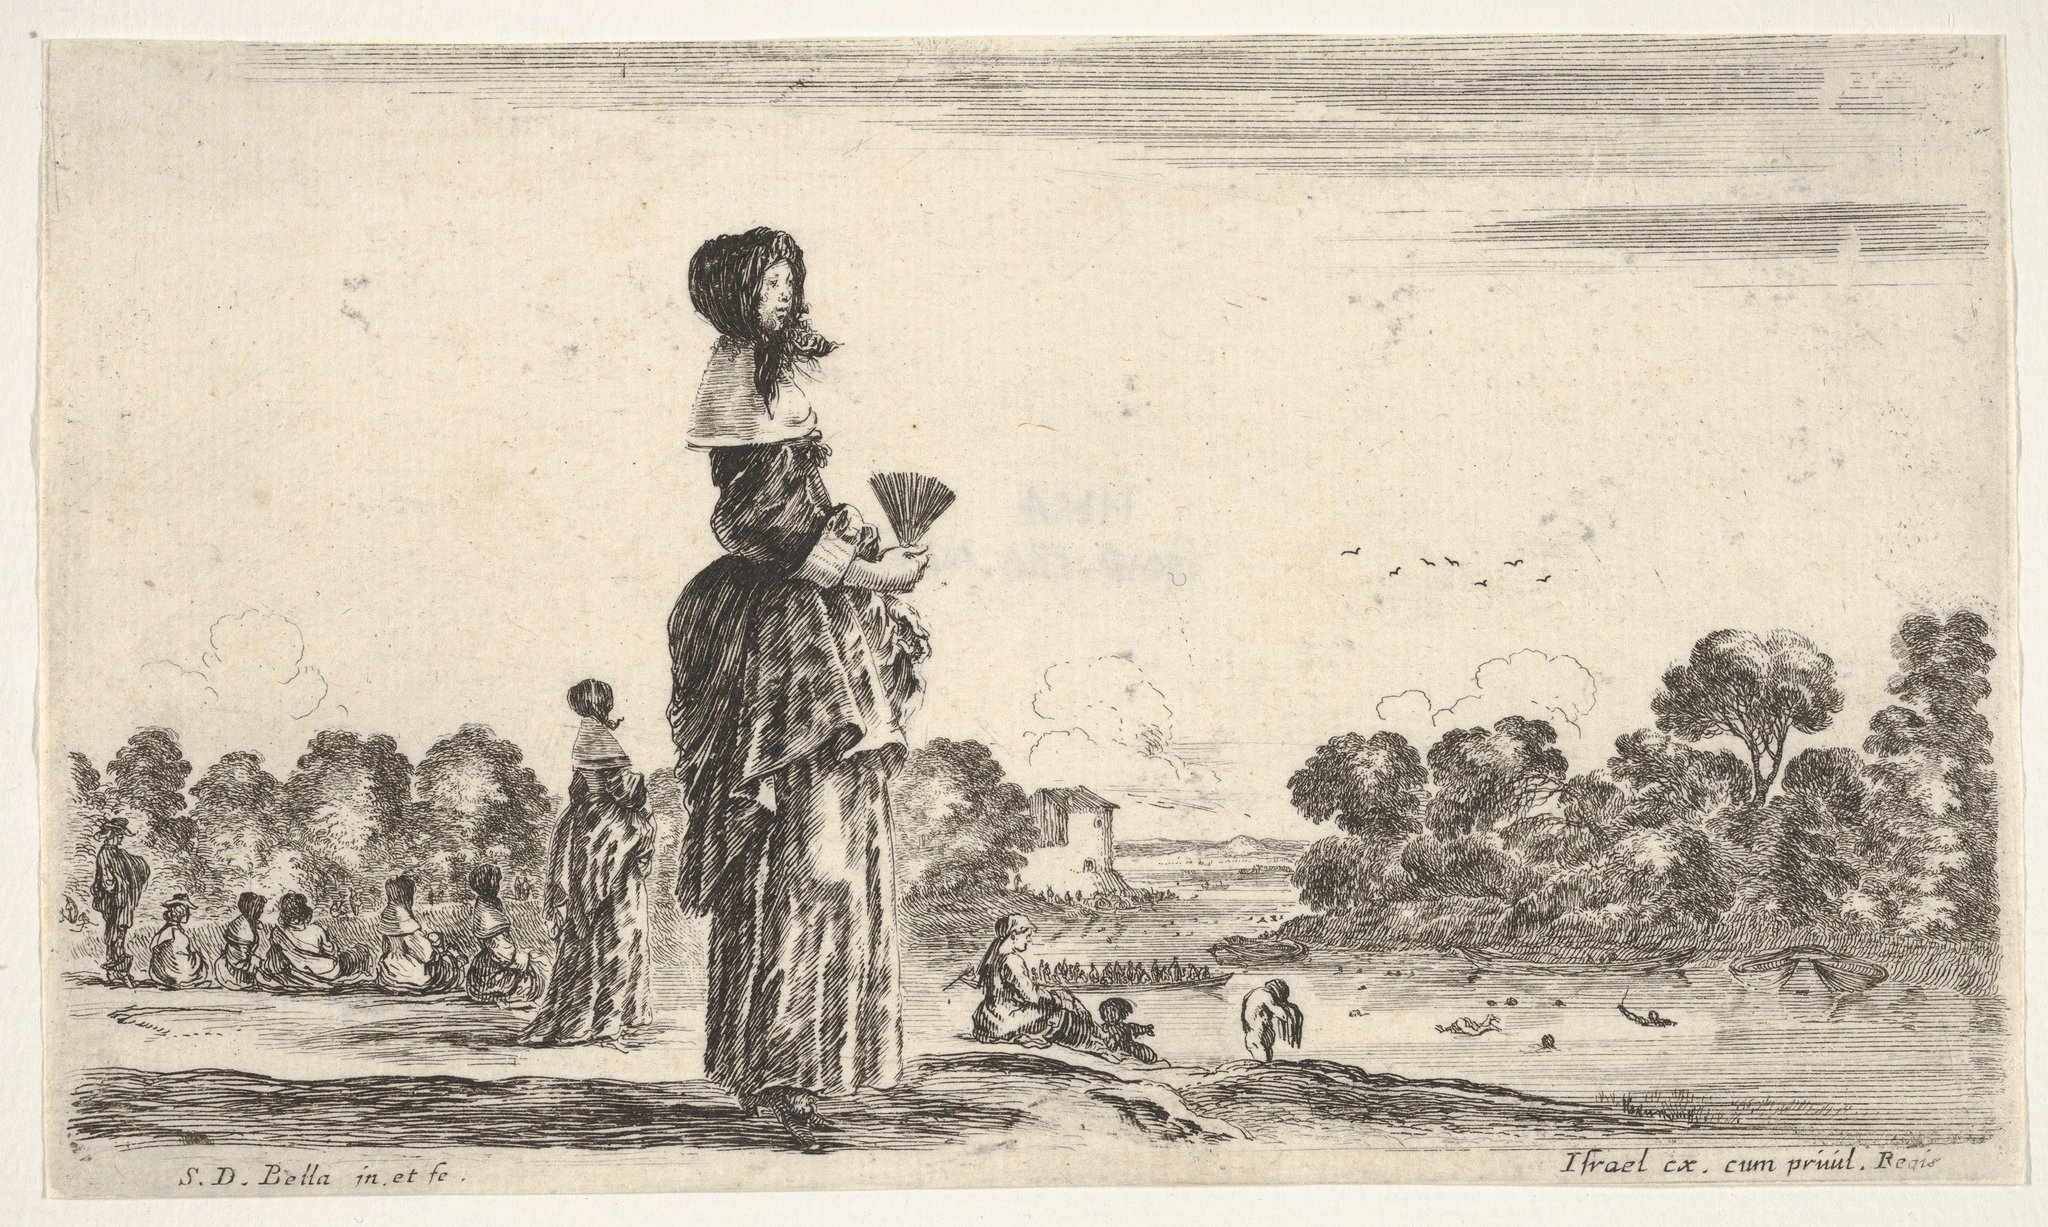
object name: print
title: A lady standing in center holding a fan watching the bathers in the river to right, other ladies and men watching bathers to left in the background, from "Various figures and lands" (Diverse figure e paesi)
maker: stefano della bella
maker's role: artist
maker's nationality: italian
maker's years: 1610-1664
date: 1649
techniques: etching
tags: fans,women,rivers,bathing